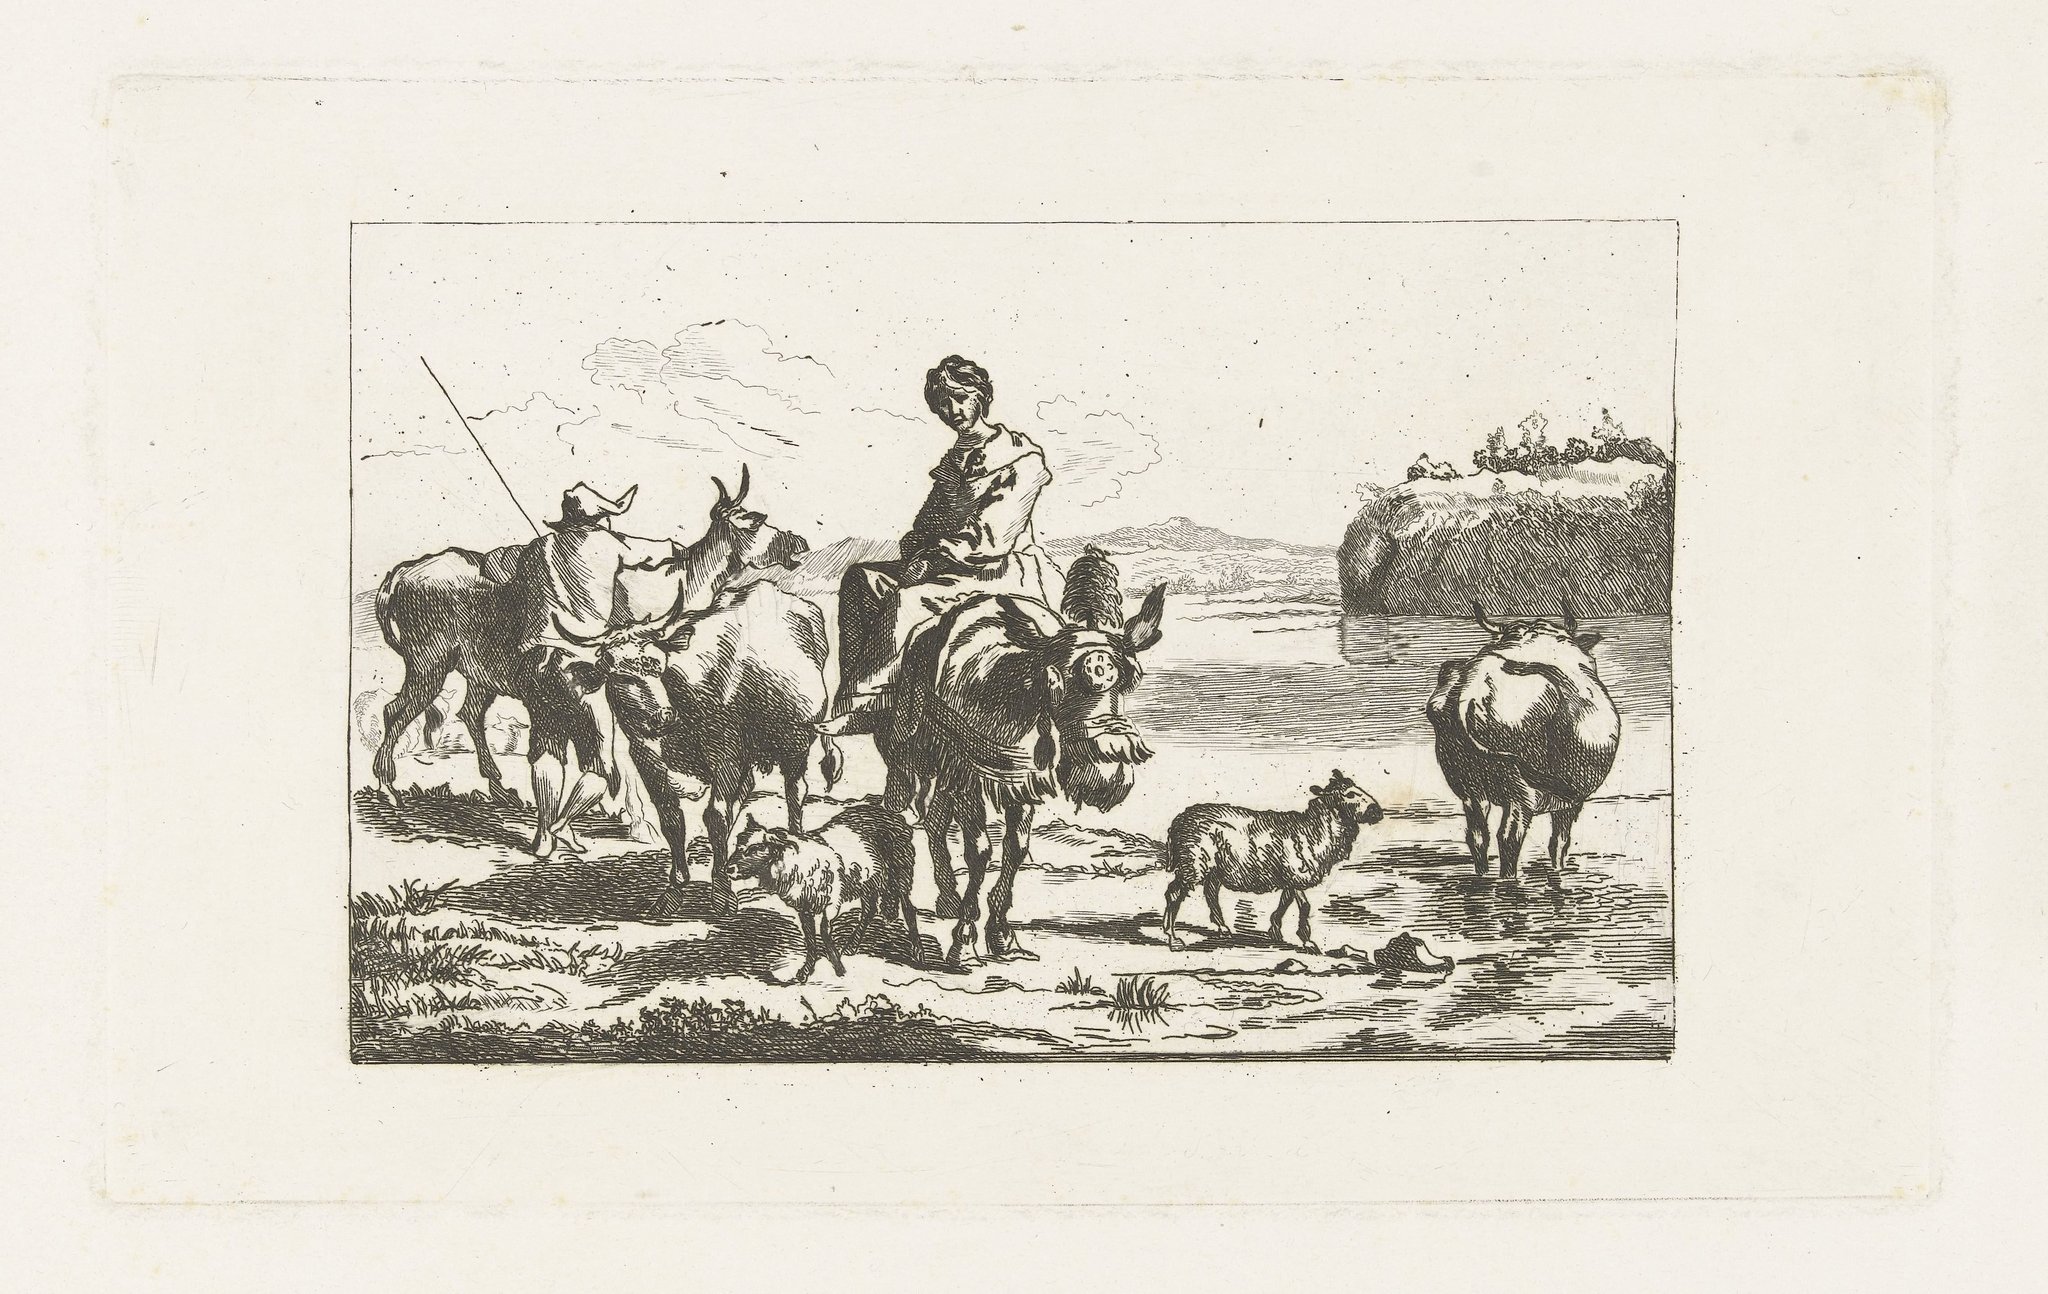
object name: print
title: Landschap met herderin op muilezel en herder met koeien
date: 1860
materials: paper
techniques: etching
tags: riding a horse, ass, or mule; rider, horseman, herding, herdsman, herdswoman, shepherd, shepherdess, cowherd, etc.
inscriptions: collector's mark: Lugt 2228